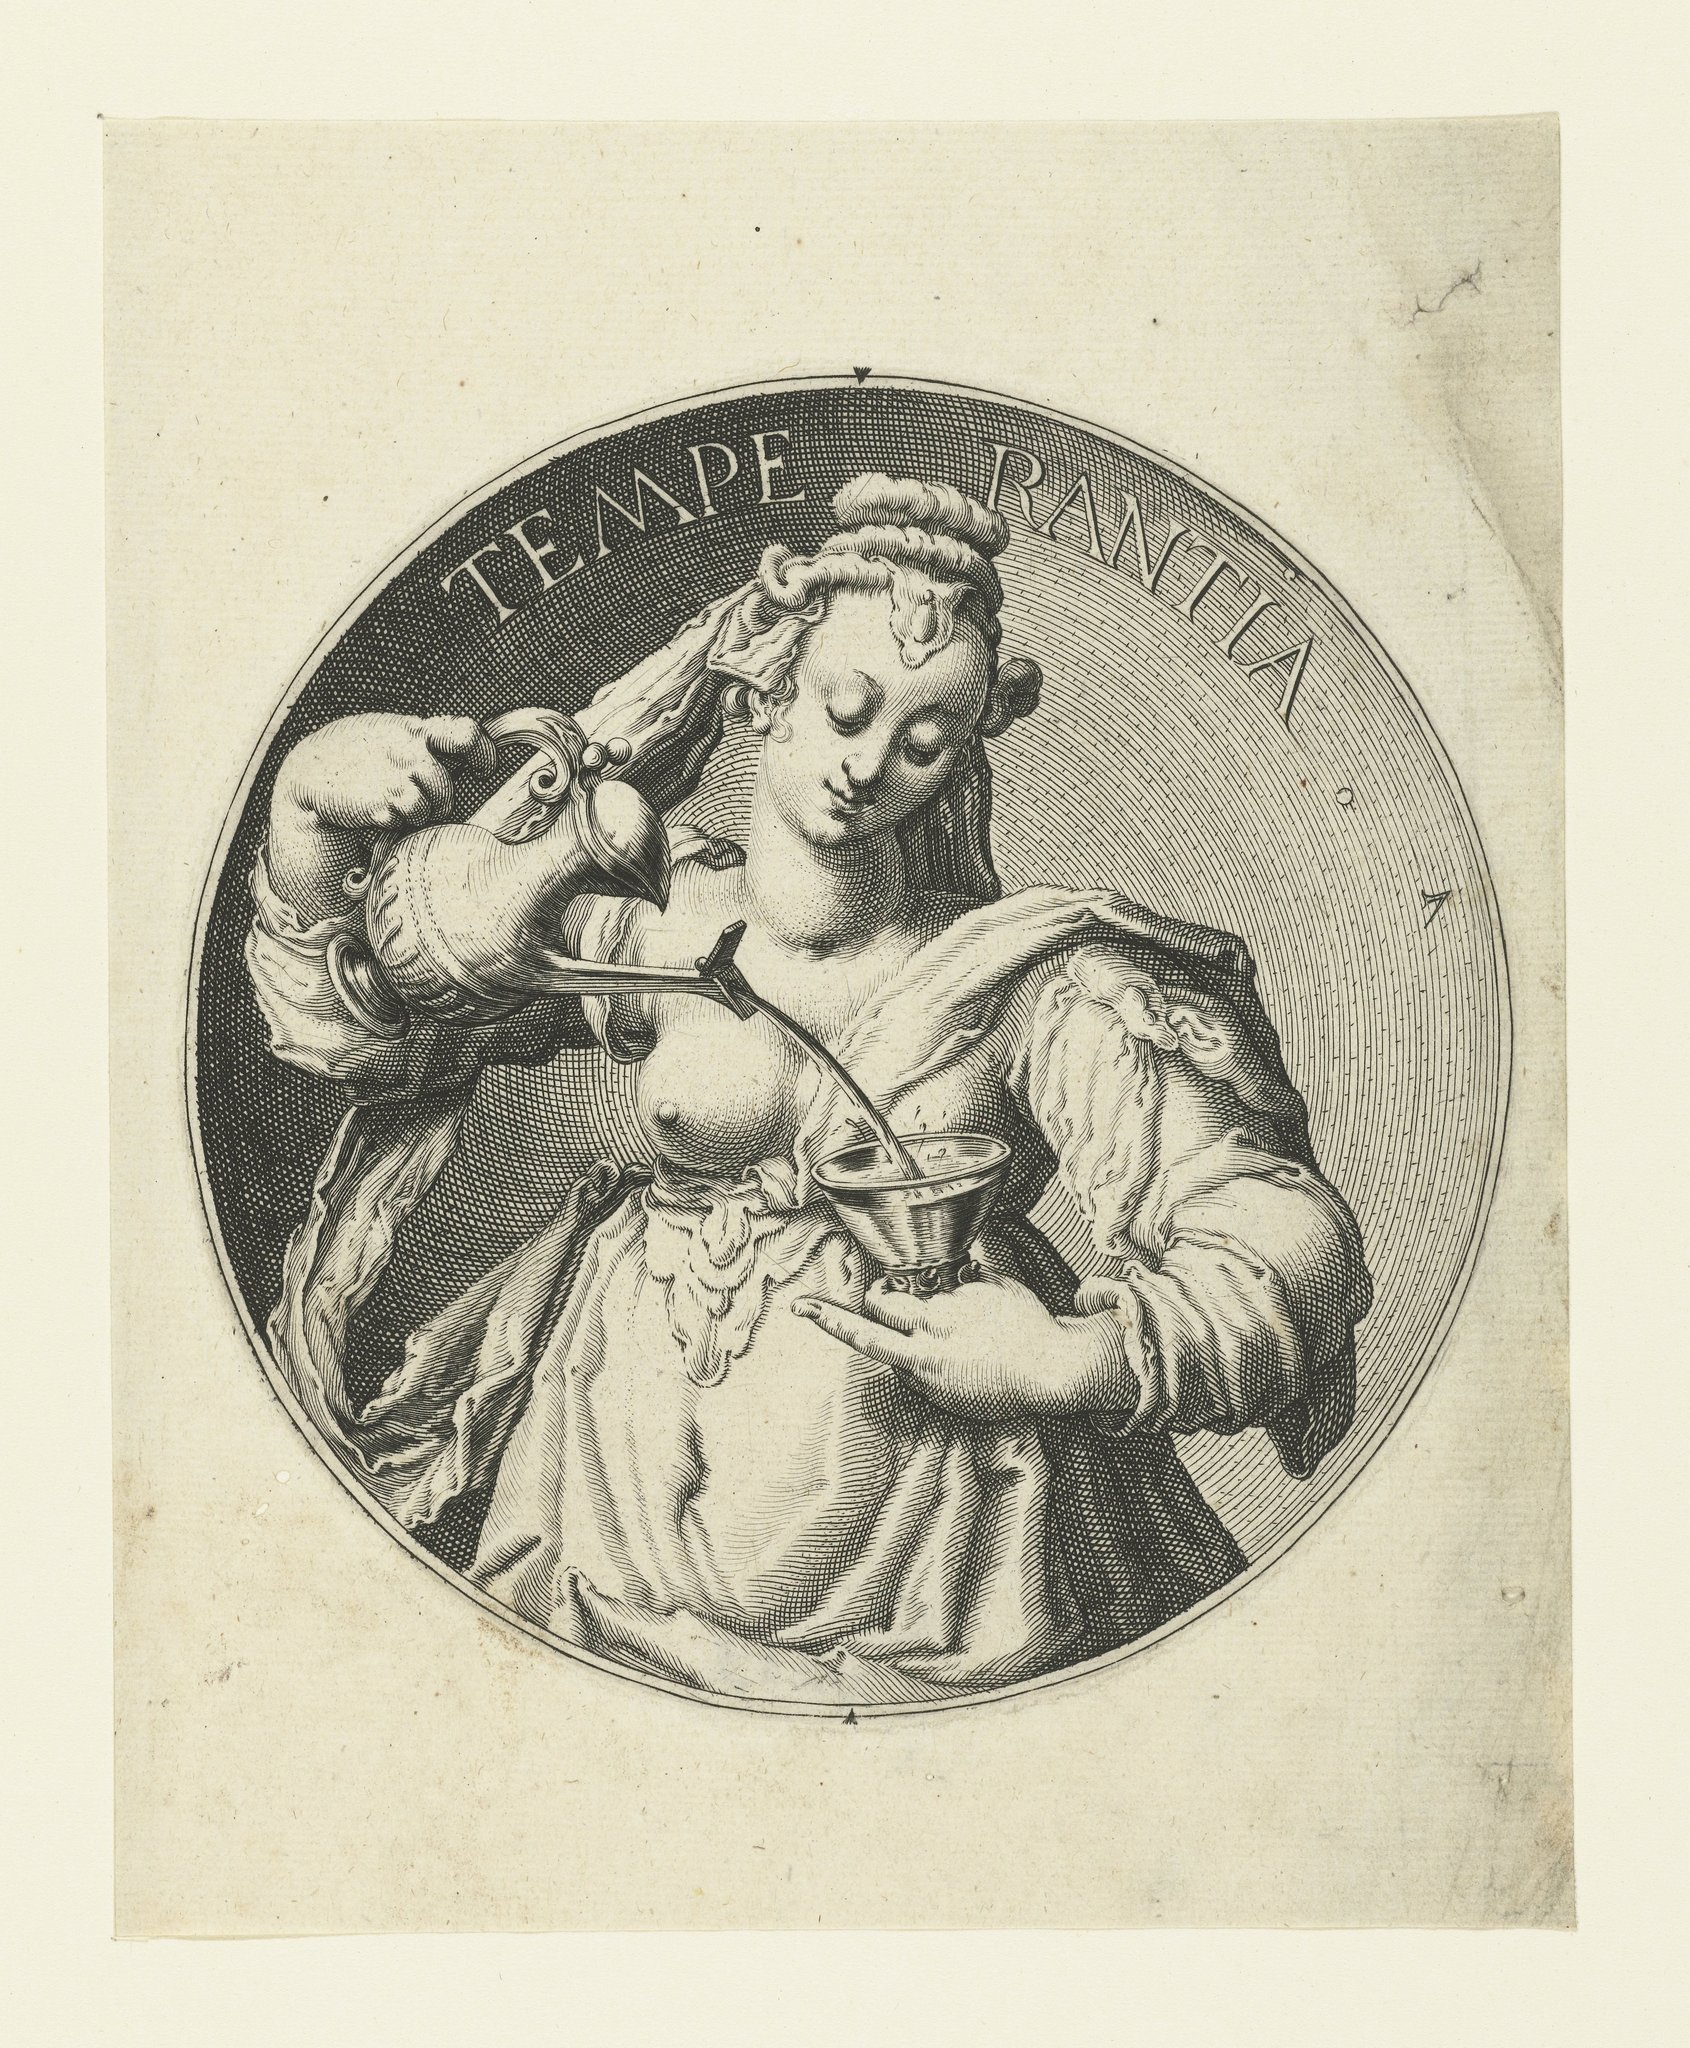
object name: print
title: De deugden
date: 1591-1595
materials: paper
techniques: engraving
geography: netherlands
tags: temperance, 'temperantia'; 'temperanza' (ripa) ~ one of the four cardinal virtues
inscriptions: collector's mark: Lugt 2228a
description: Matigheid, in de gedaante van een vrouw die water uit een kan in een glas schenkt. Bovenin de voorstelling het woord 'TEMPERANTIA.' (standvastigheid). Deze prent is onderdeel van een serie van zeven ronde voorstellingen van de deugden, elk gepersonifieerd door een vrouwenfiguur met typerende attributen, en met Latijns opschrift, en met Latijns opschrift.